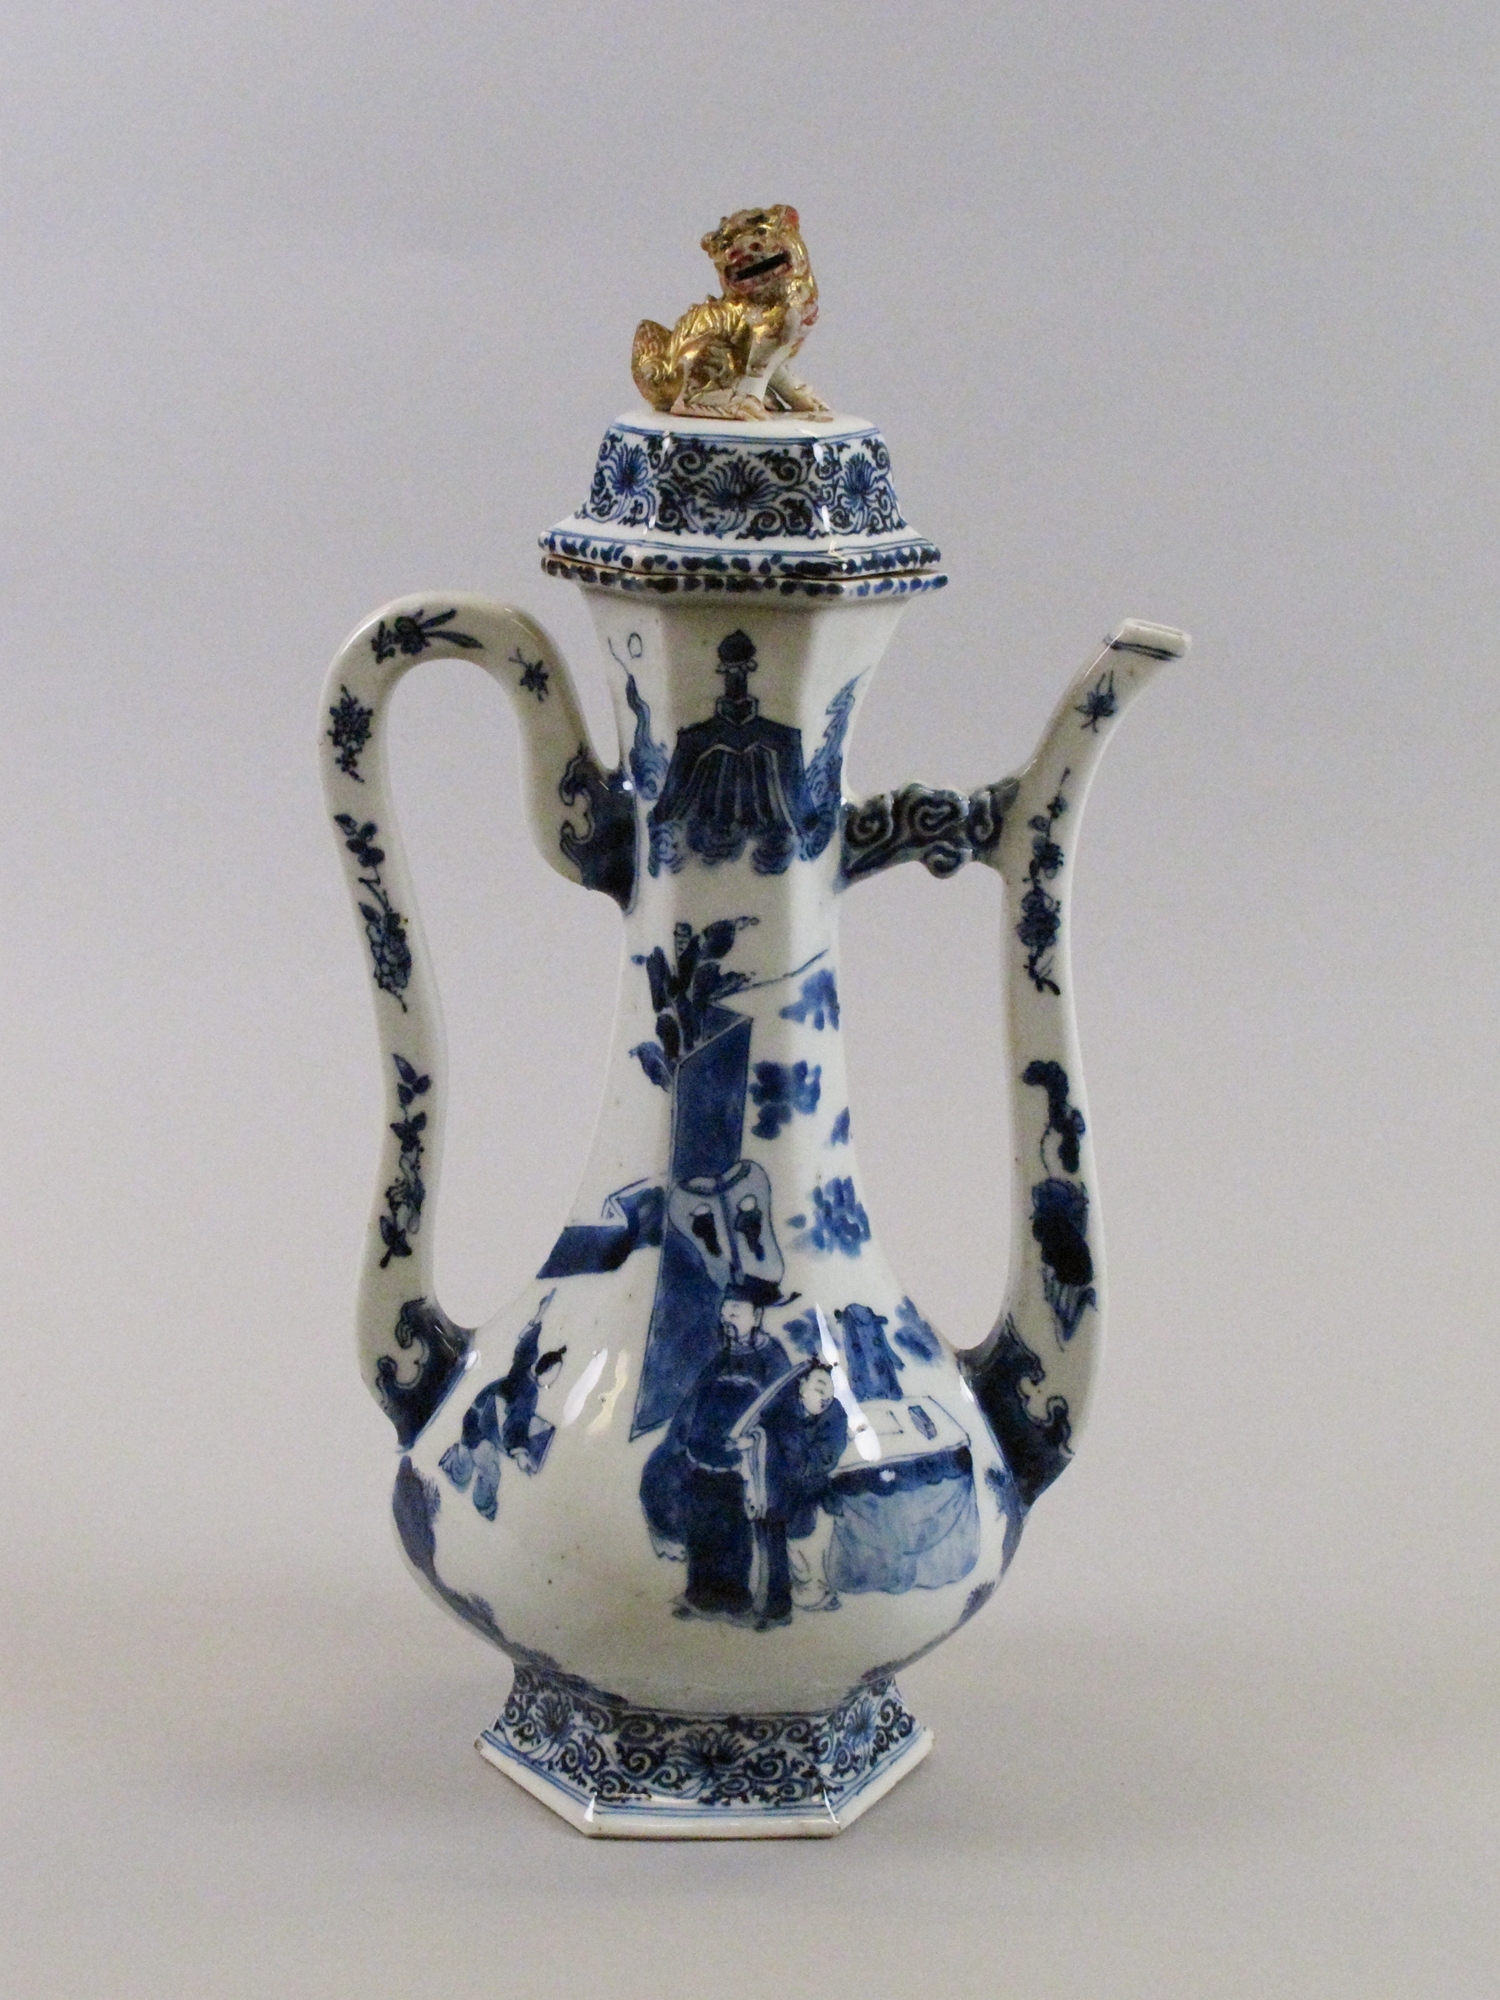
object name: covered ewer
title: Covered ewer with figures in a garden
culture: chinese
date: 1667-1733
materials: cobalt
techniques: painting, underglaze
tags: men